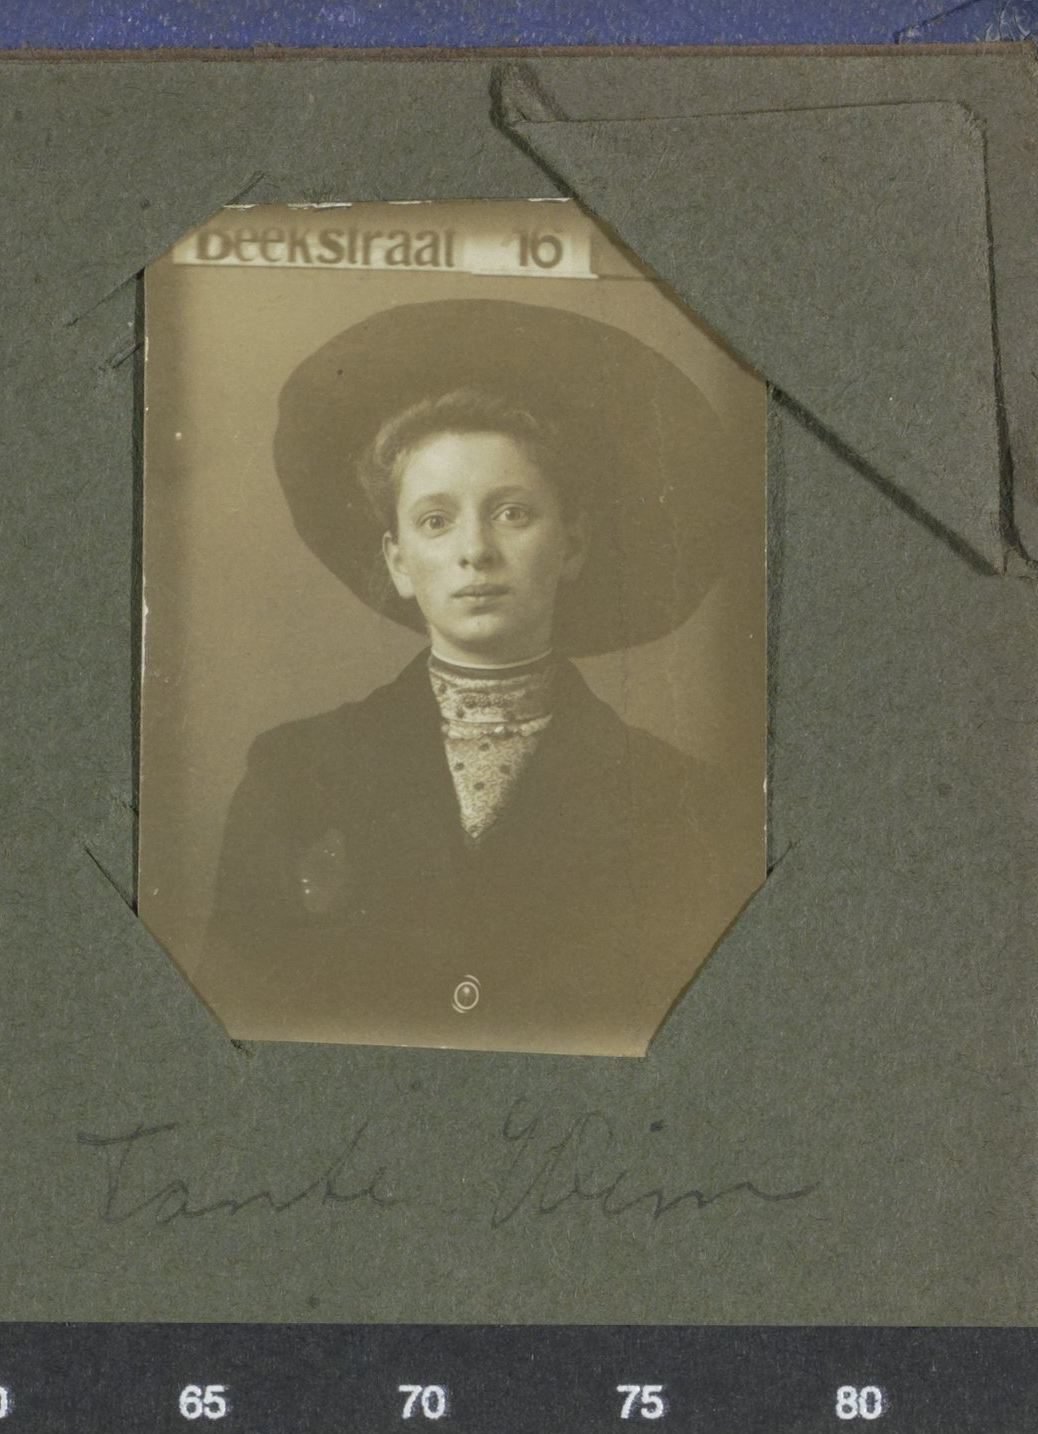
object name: snapshot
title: Portret van een vrouw met een hoed, aangeduid als 'Tante Wim'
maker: Anonymous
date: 1910-1920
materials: cardboard, paper, photographic support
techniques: gelatin silver print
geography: netherlands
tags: adult woman, historical persons, head-gear: hat, netherlands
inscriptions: address: ‘Beekstraat 16’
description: Onderdeel van Album met automaatfoto's van een Nederlandse familie.